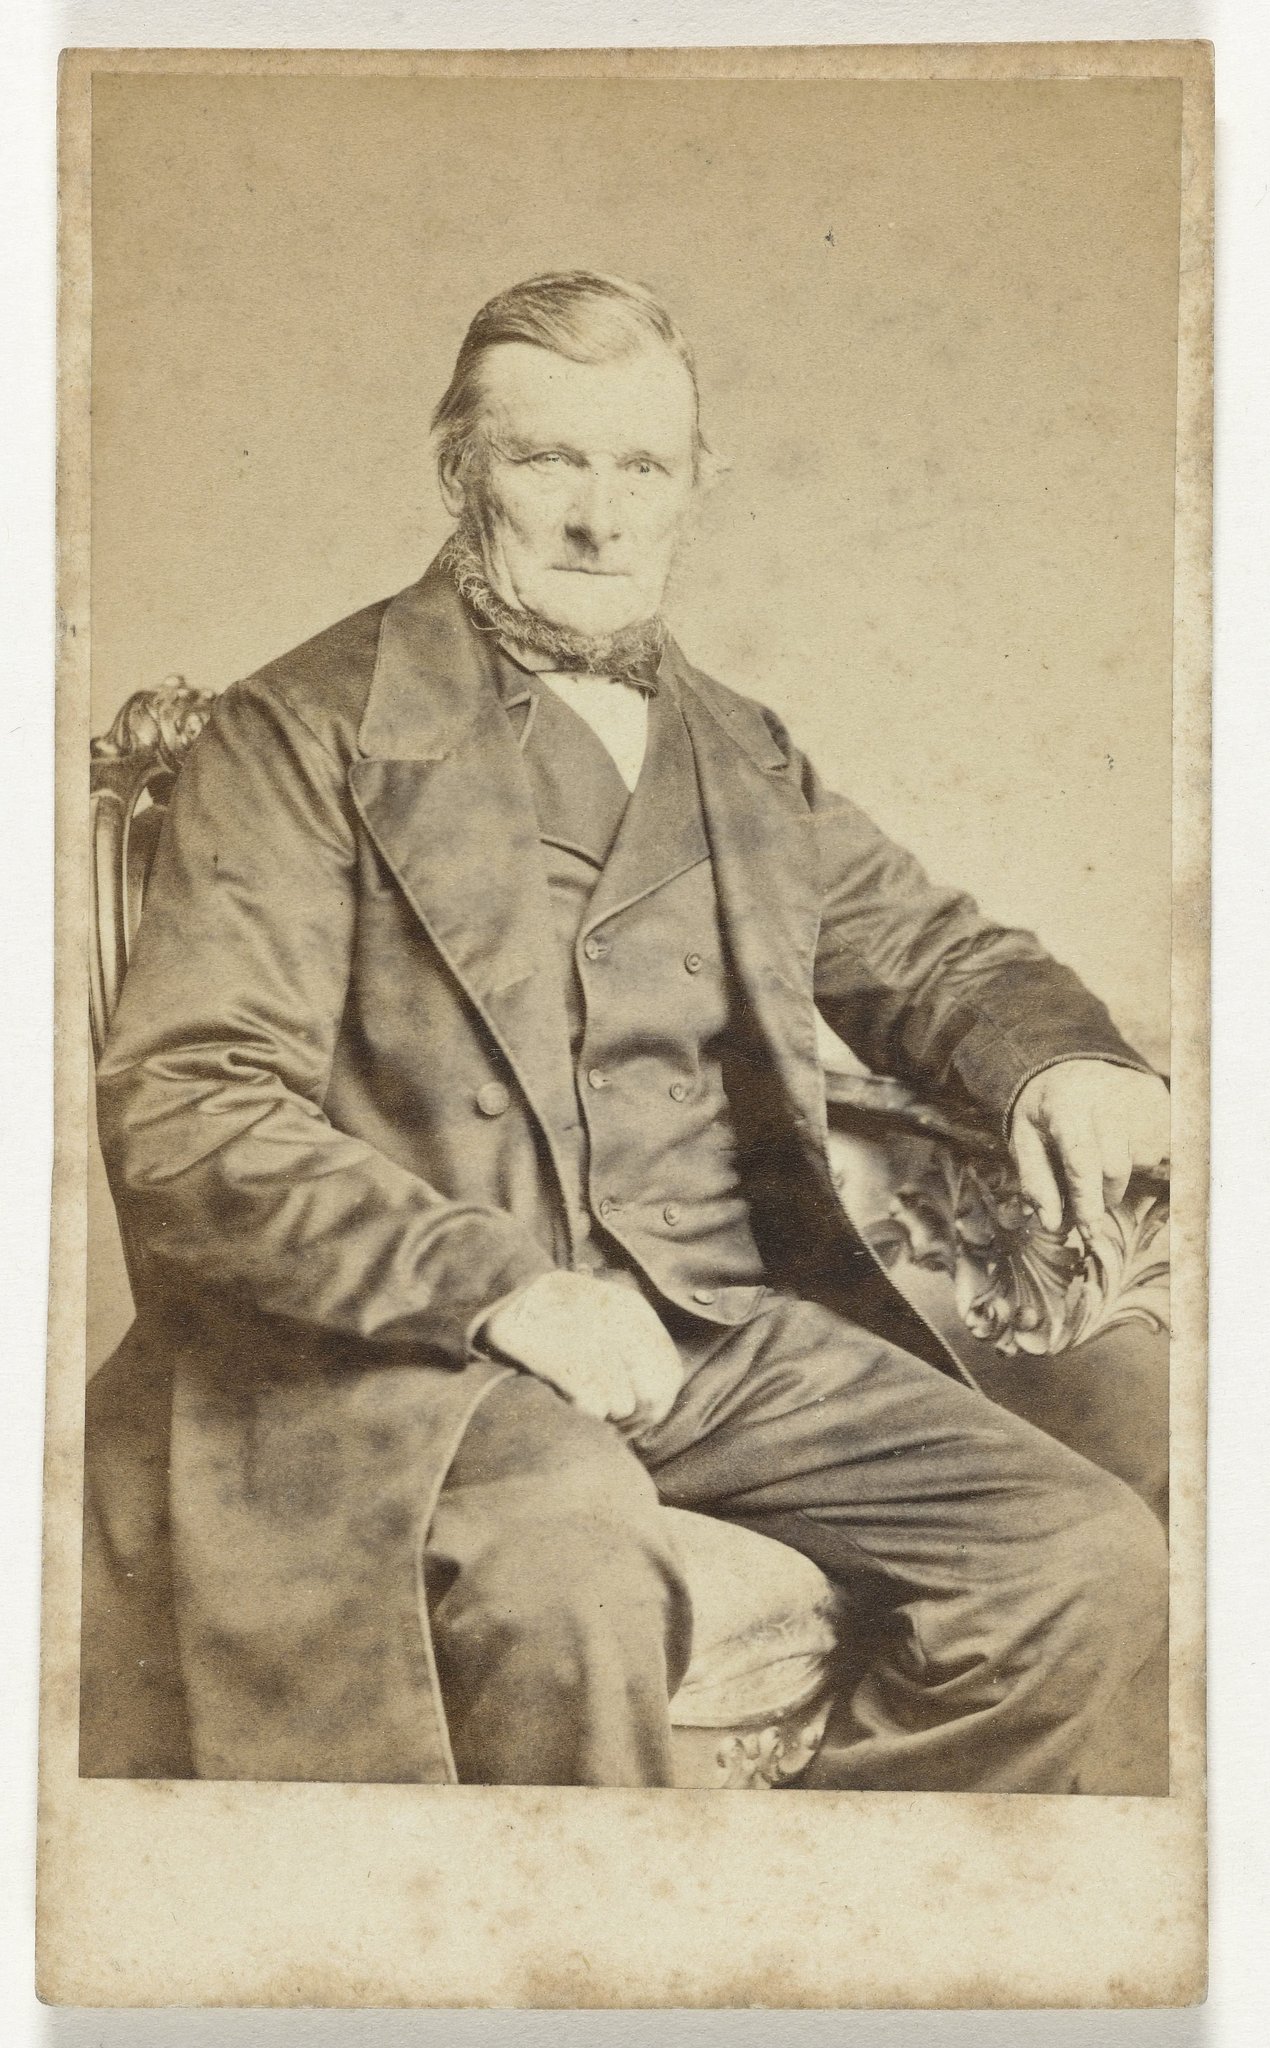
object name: carte de visite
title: Portret van een oudere man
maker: peter carstensen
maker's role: fotograaf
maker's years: 1817-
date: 1860-1880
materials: cardboard, paper, photographic support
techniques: albumen print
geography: amsterdam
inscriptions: address: ‘PHOTOGRAFISCH ATELIER // P. CARSTENSEN // Nieuwendijk H 201 // AMSTERDAM // AMSTERDAM’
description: Portret van een oudere man, zittend naast een tafel.